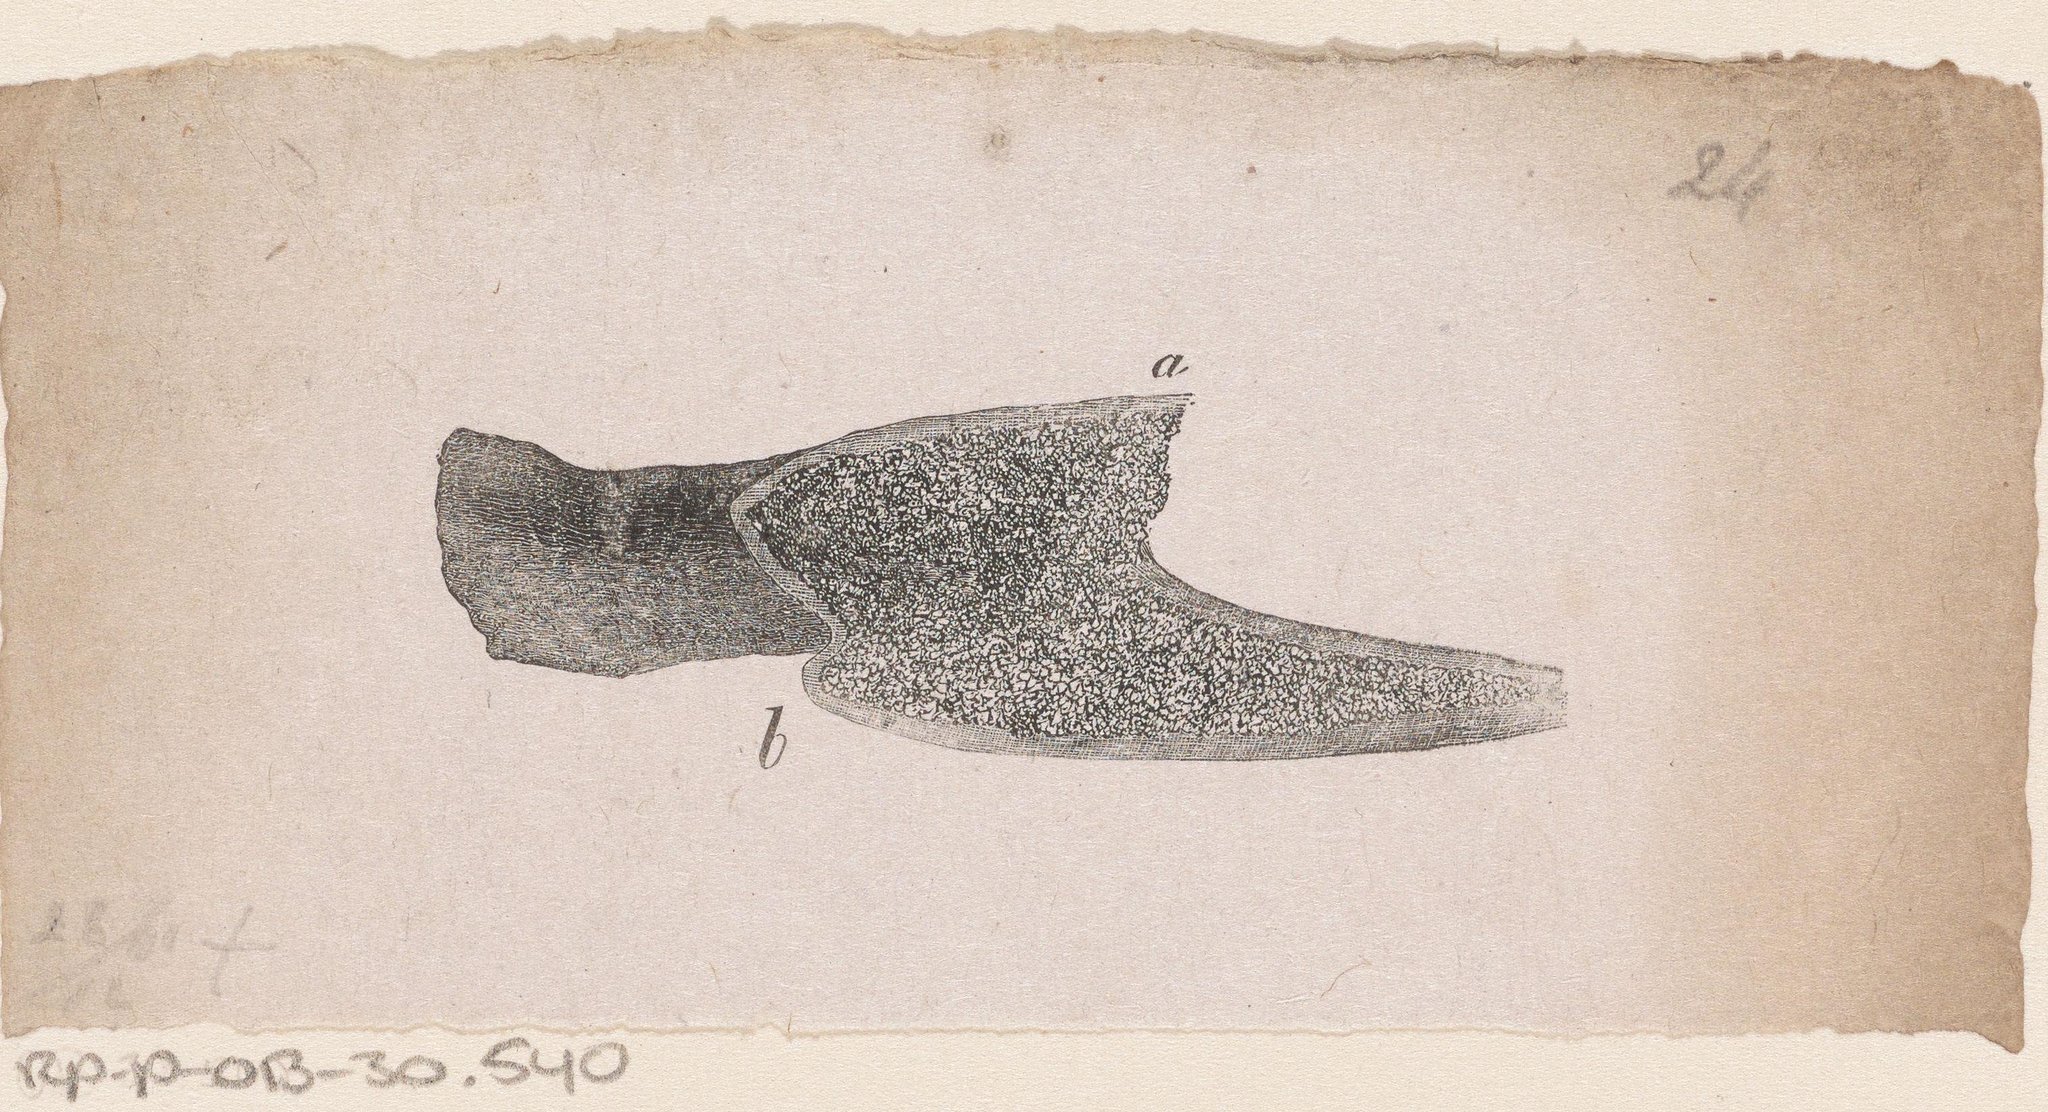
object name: print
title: Menselijk bot met een afwijking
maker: isaac weissenbruch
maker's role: print maker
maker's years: 1826-1912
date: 1836-1912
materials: paper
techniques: engraving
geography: netherlands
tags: bones in general (human body), diseases